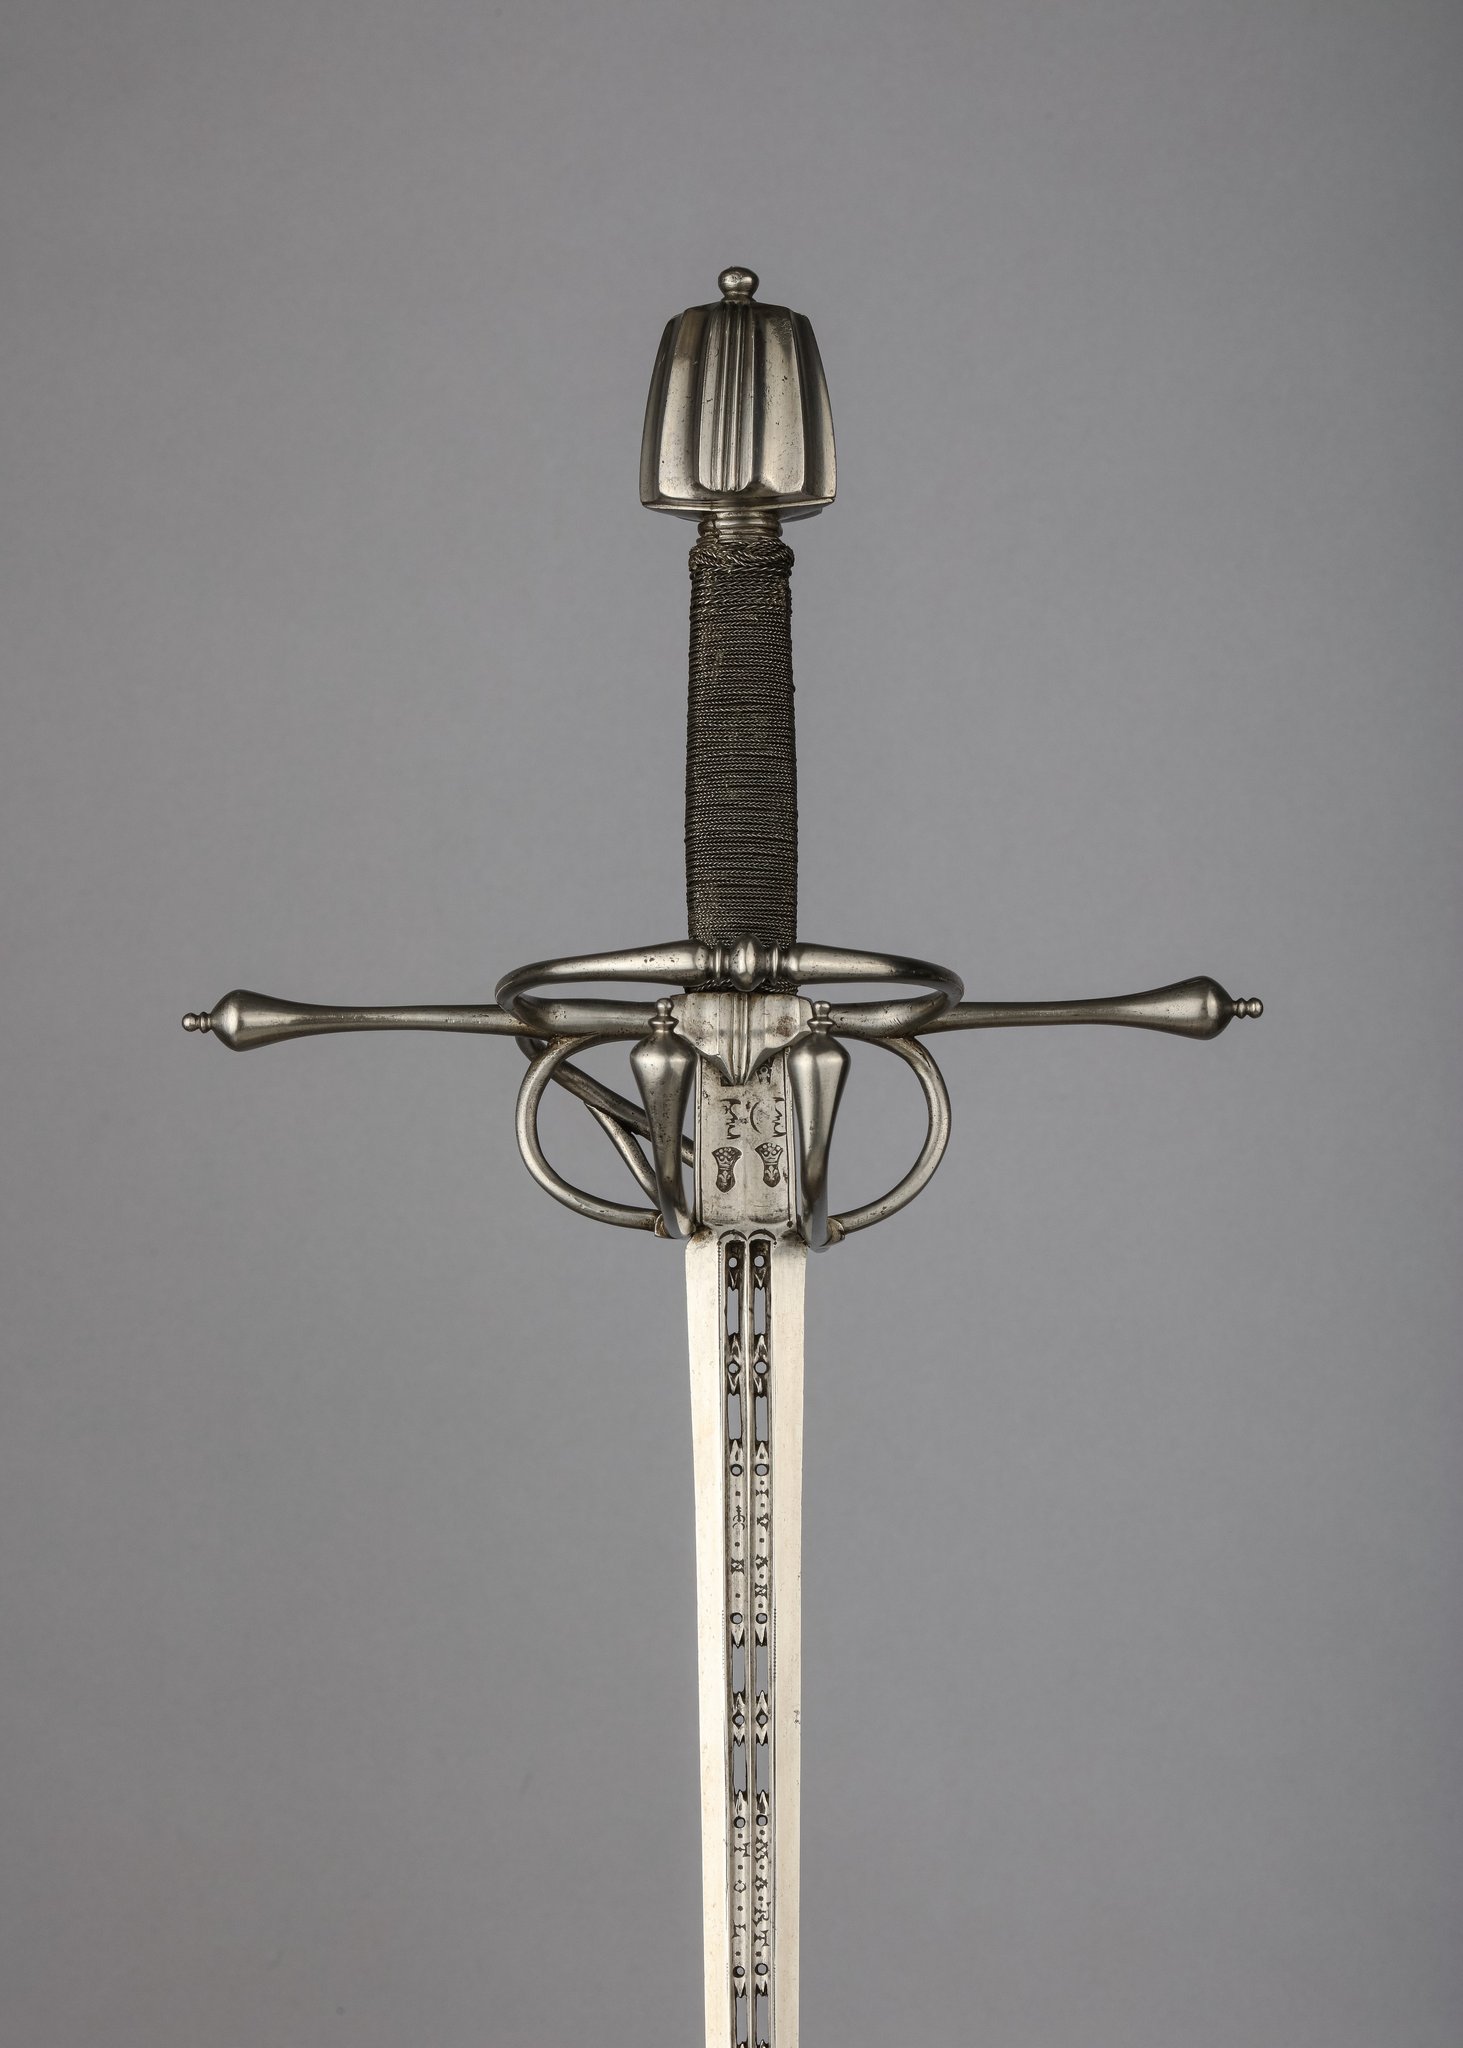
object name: rapier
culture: spanish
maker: juan martinez the elder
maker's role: bladesmith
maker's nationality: spanish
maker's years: 1525-1575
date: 1534-1566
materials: steel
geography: spain